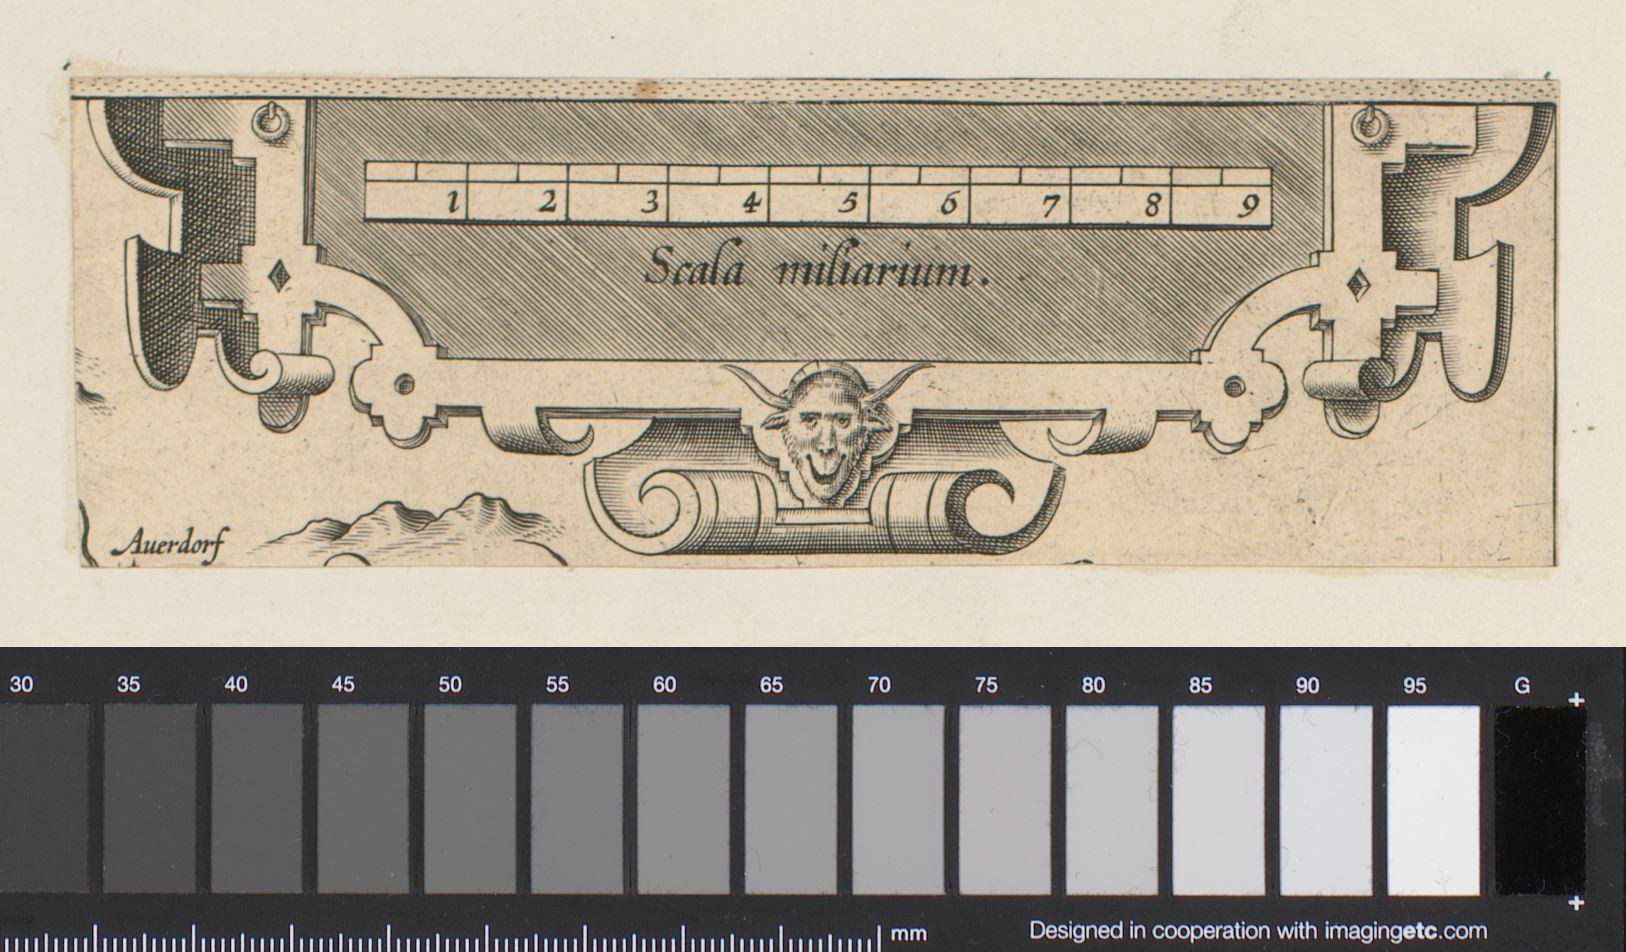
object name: album leaf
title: Cartouche van een kaart van Salzburg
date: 1592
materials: paper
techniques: engraving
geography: antwerp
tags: scrollwork, strapwork ~ ornament, ornament ~ cartouche, mask, mascaron ~ ornament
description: De cartouche is gebaseerd op een prent van een anonieme graveur naar het ontwerp van Hans Vredeman de Vries, onderdeel van een serie van rolwerkcartouches met grotesken uit circa 1555-1560.